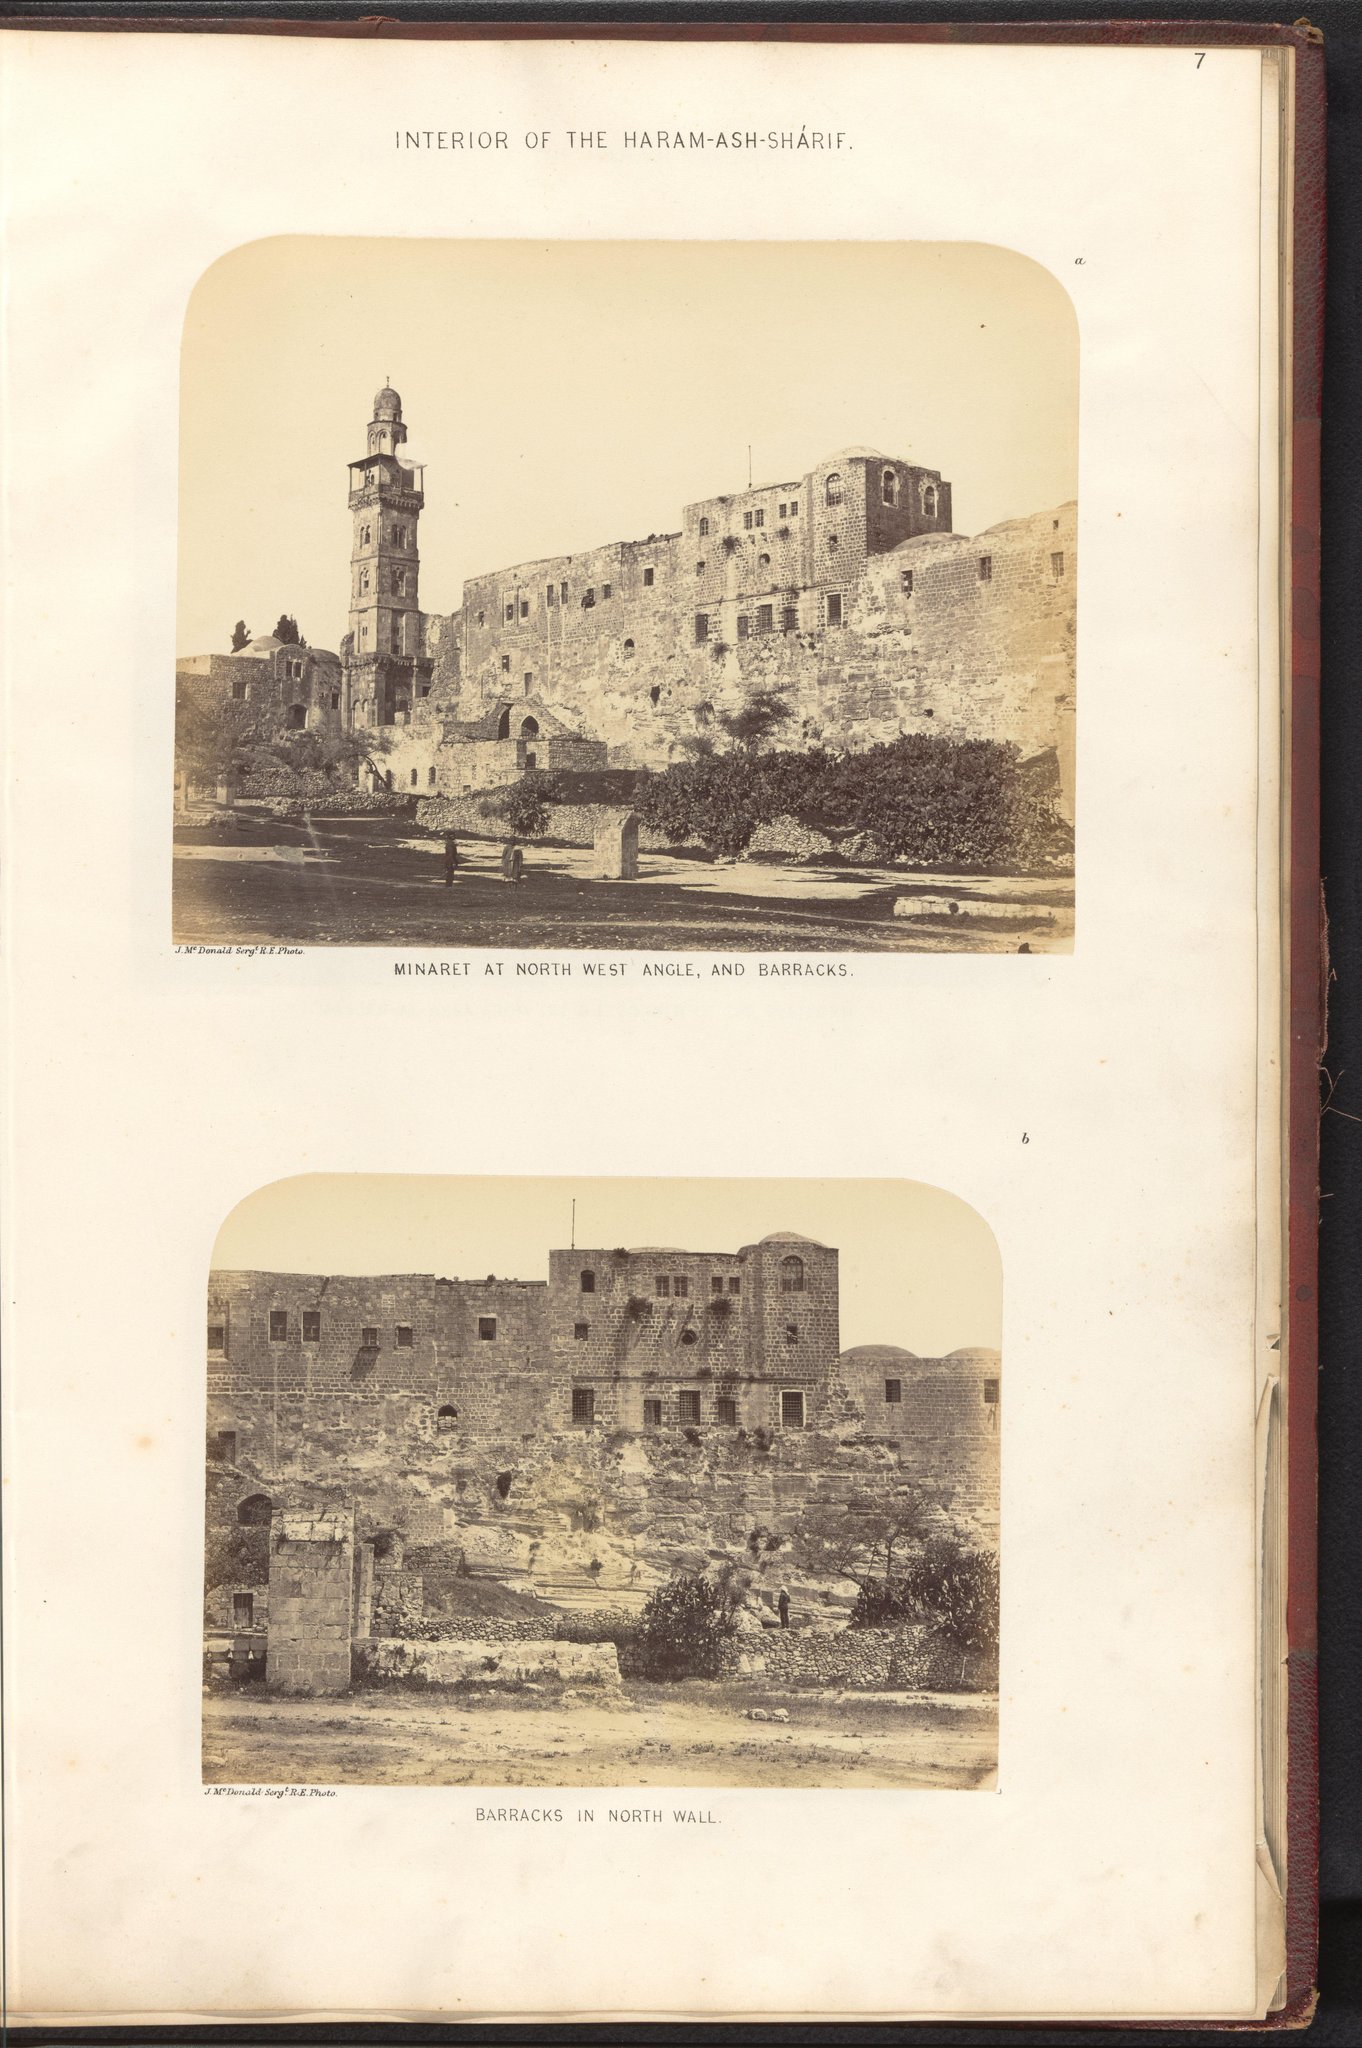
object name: photograph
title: Minaret at North West Angle, and Barracks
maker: james mcdonald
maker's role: fotograaf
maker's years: 1822-1885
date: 1860-1865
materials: paper, photographic support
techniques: albumen print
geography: tempelberg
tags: housing, temple, shrine ~ islam, mohammedanism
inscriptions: inscription: ‘b’, inscription: ‘a’